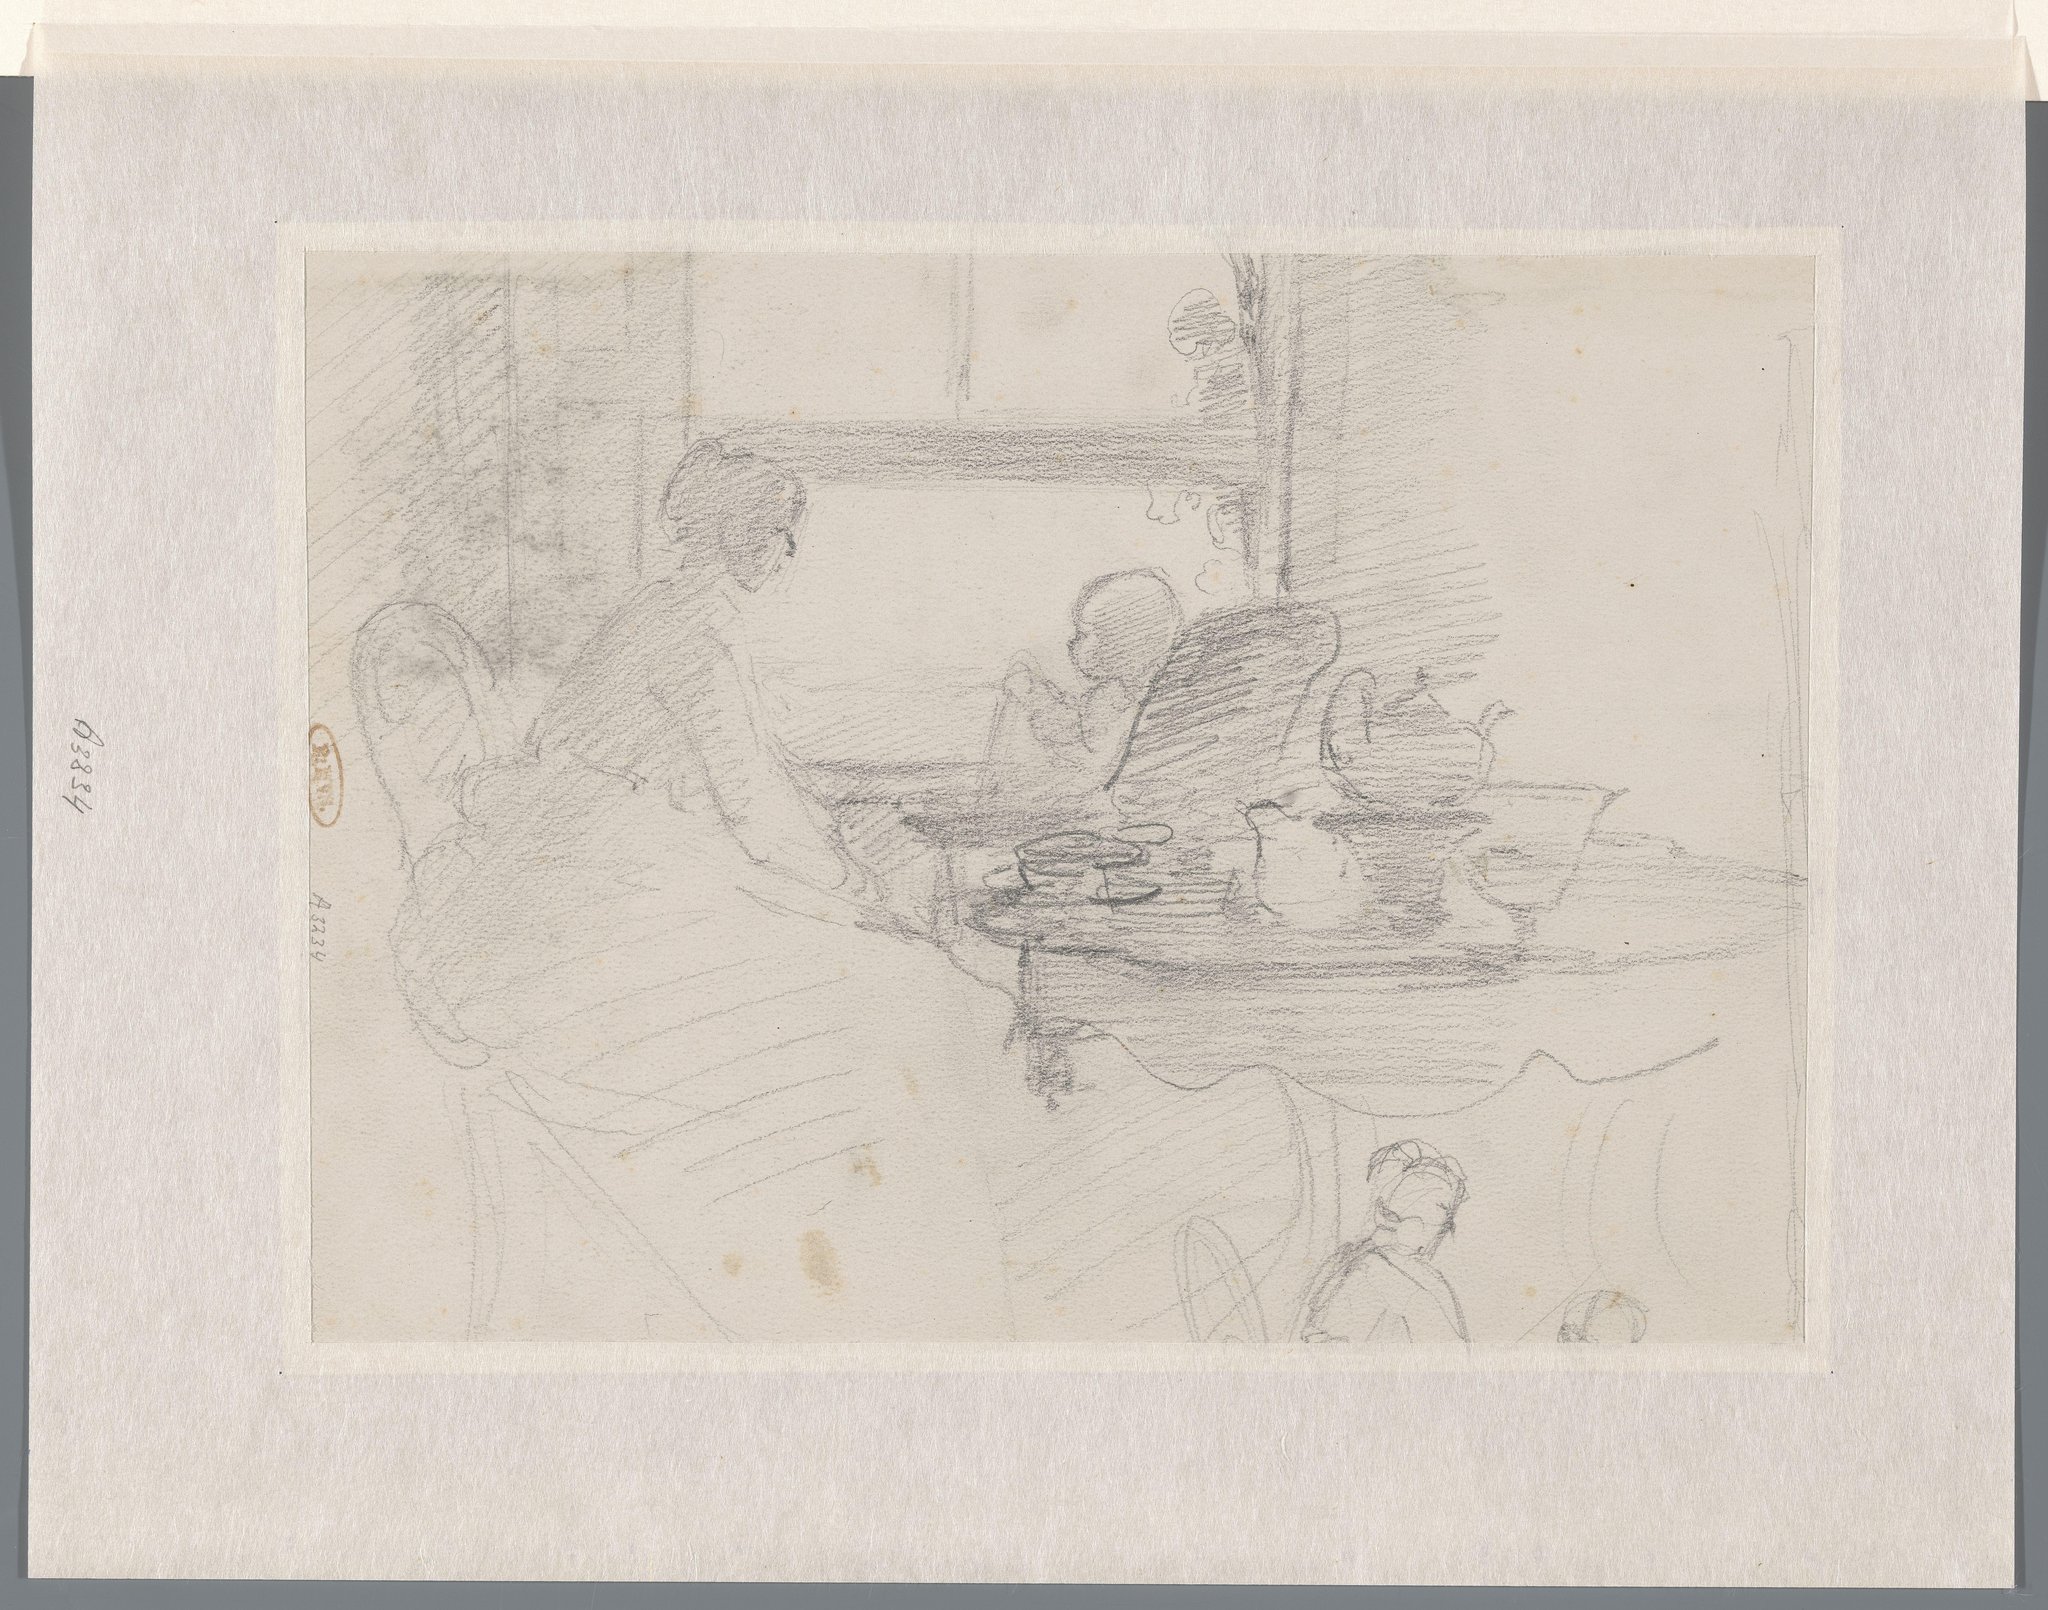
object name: drawing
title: Interieur met een moeder en een kind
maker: hendrik valkenburg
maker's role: draughtsman, painter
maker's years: 1826-1896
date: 1836-1896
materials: chalk, paper, pencil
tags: child between toddler and youth (of undetermined sex)